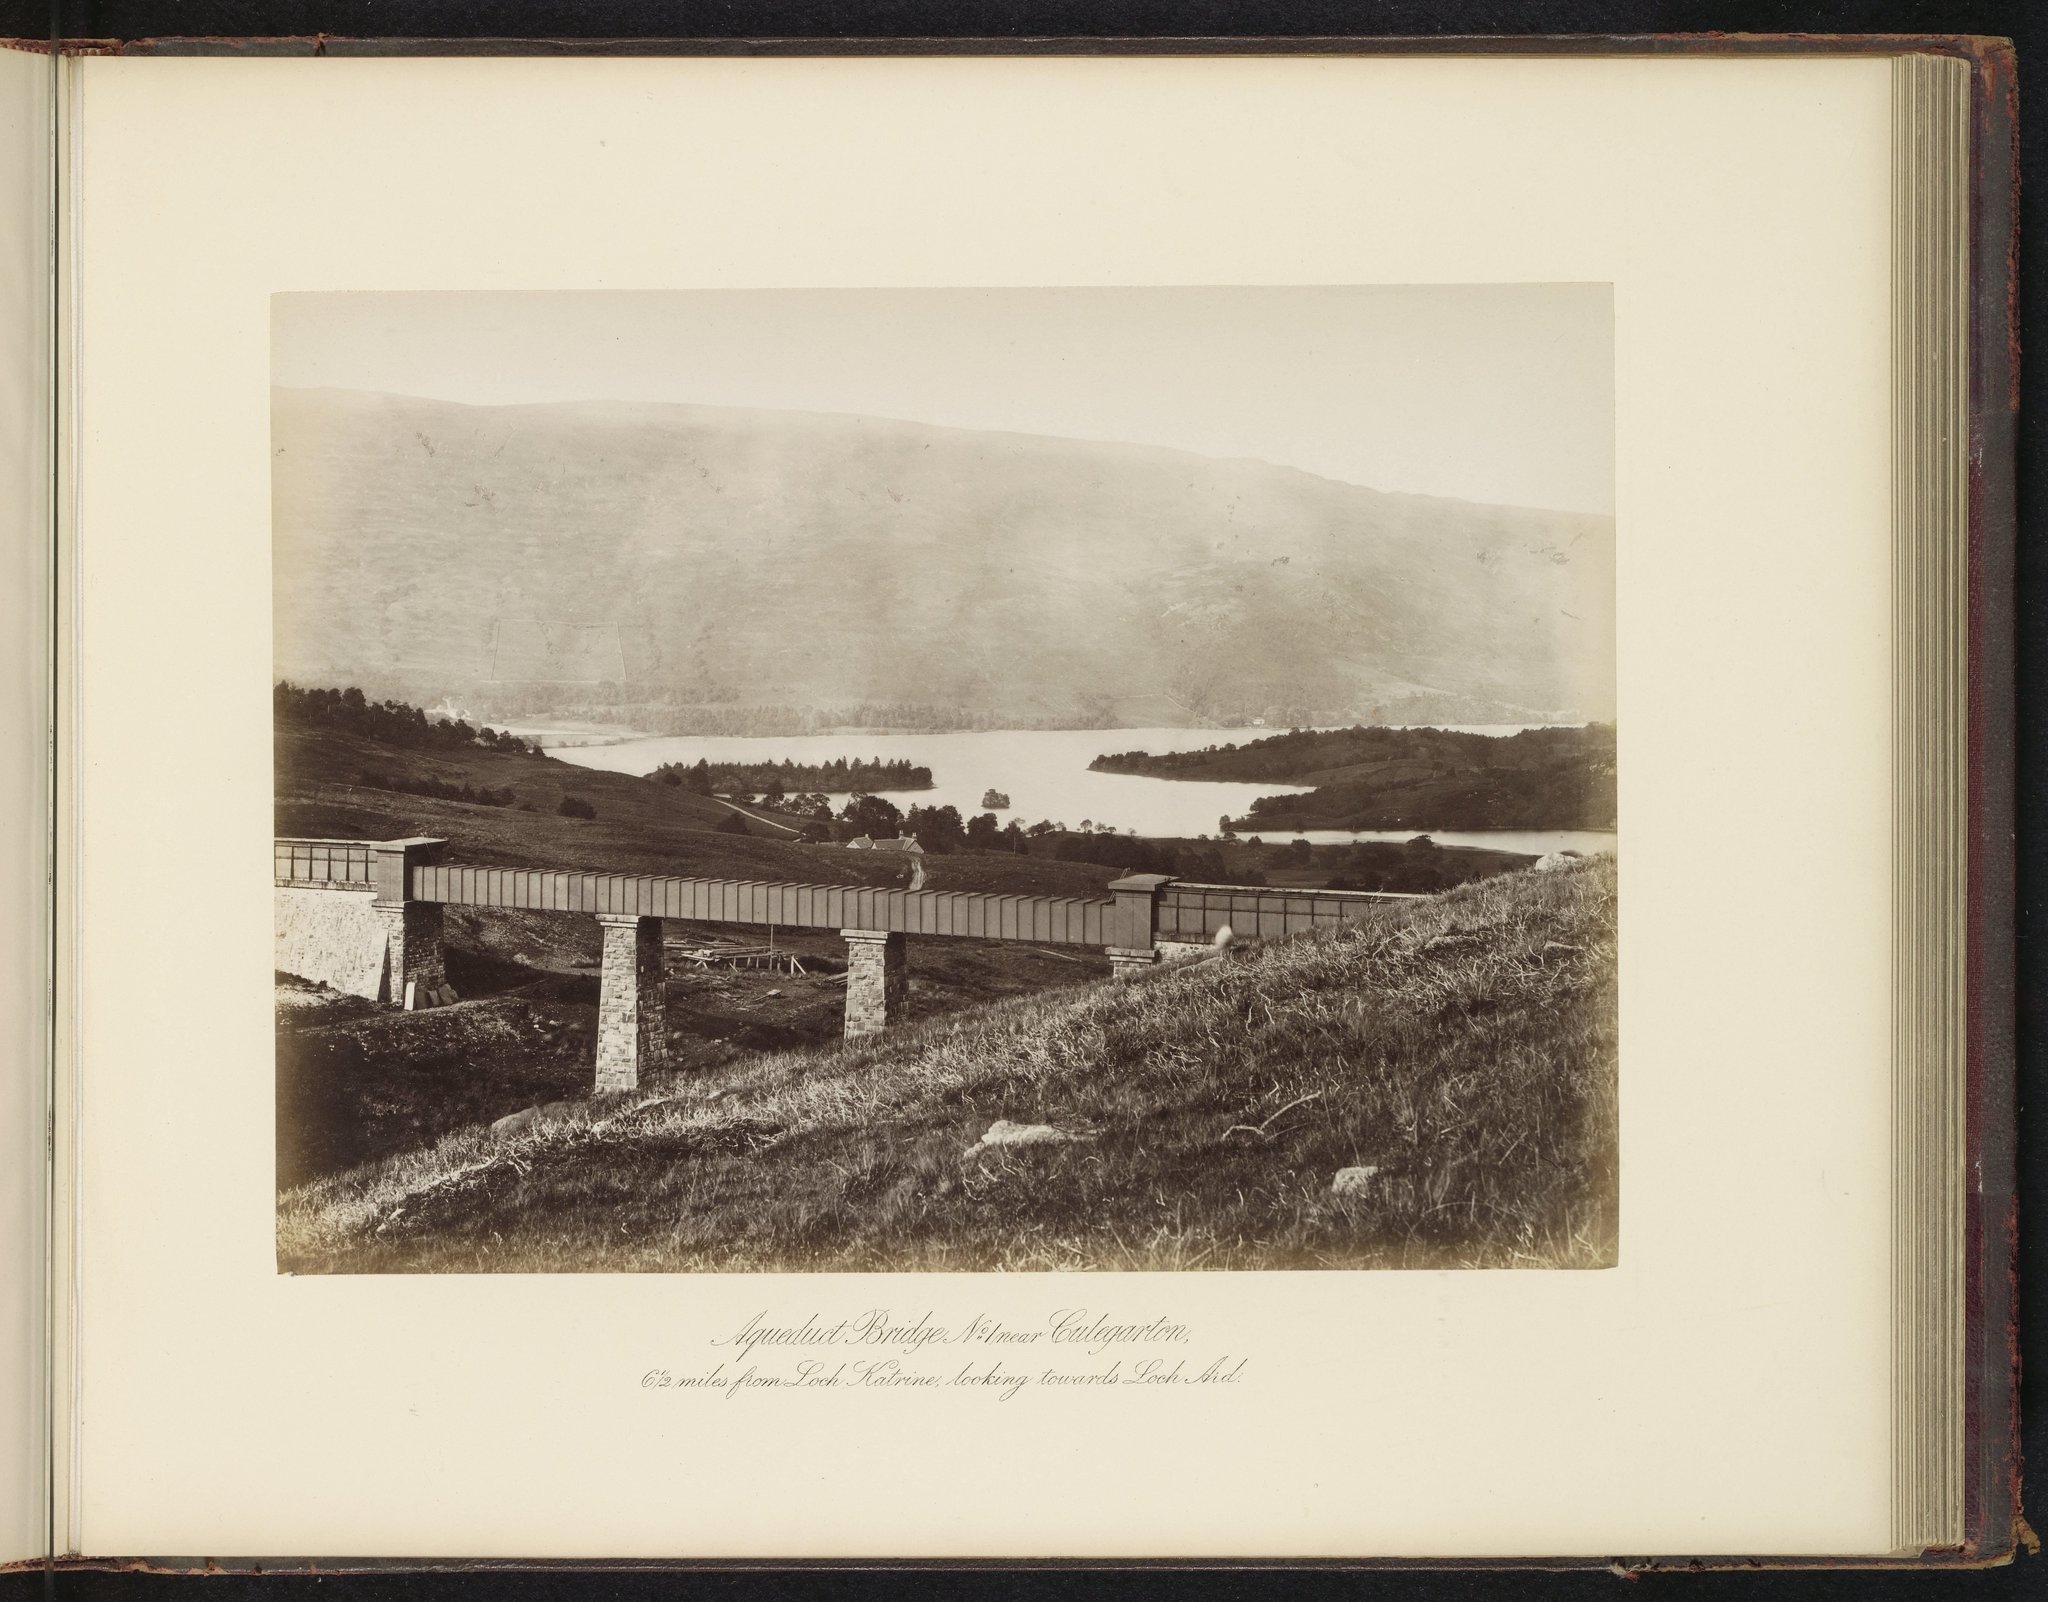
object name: page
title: Aqueduct bridge, No 1 near Culegarten, 6 1/2 miles from Loch Katrine, looking towards Loch Ard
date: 1879-1889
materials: photographic support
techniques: albumen print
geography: stirling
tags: low hill country, lake, aqueduct (~ water supply)